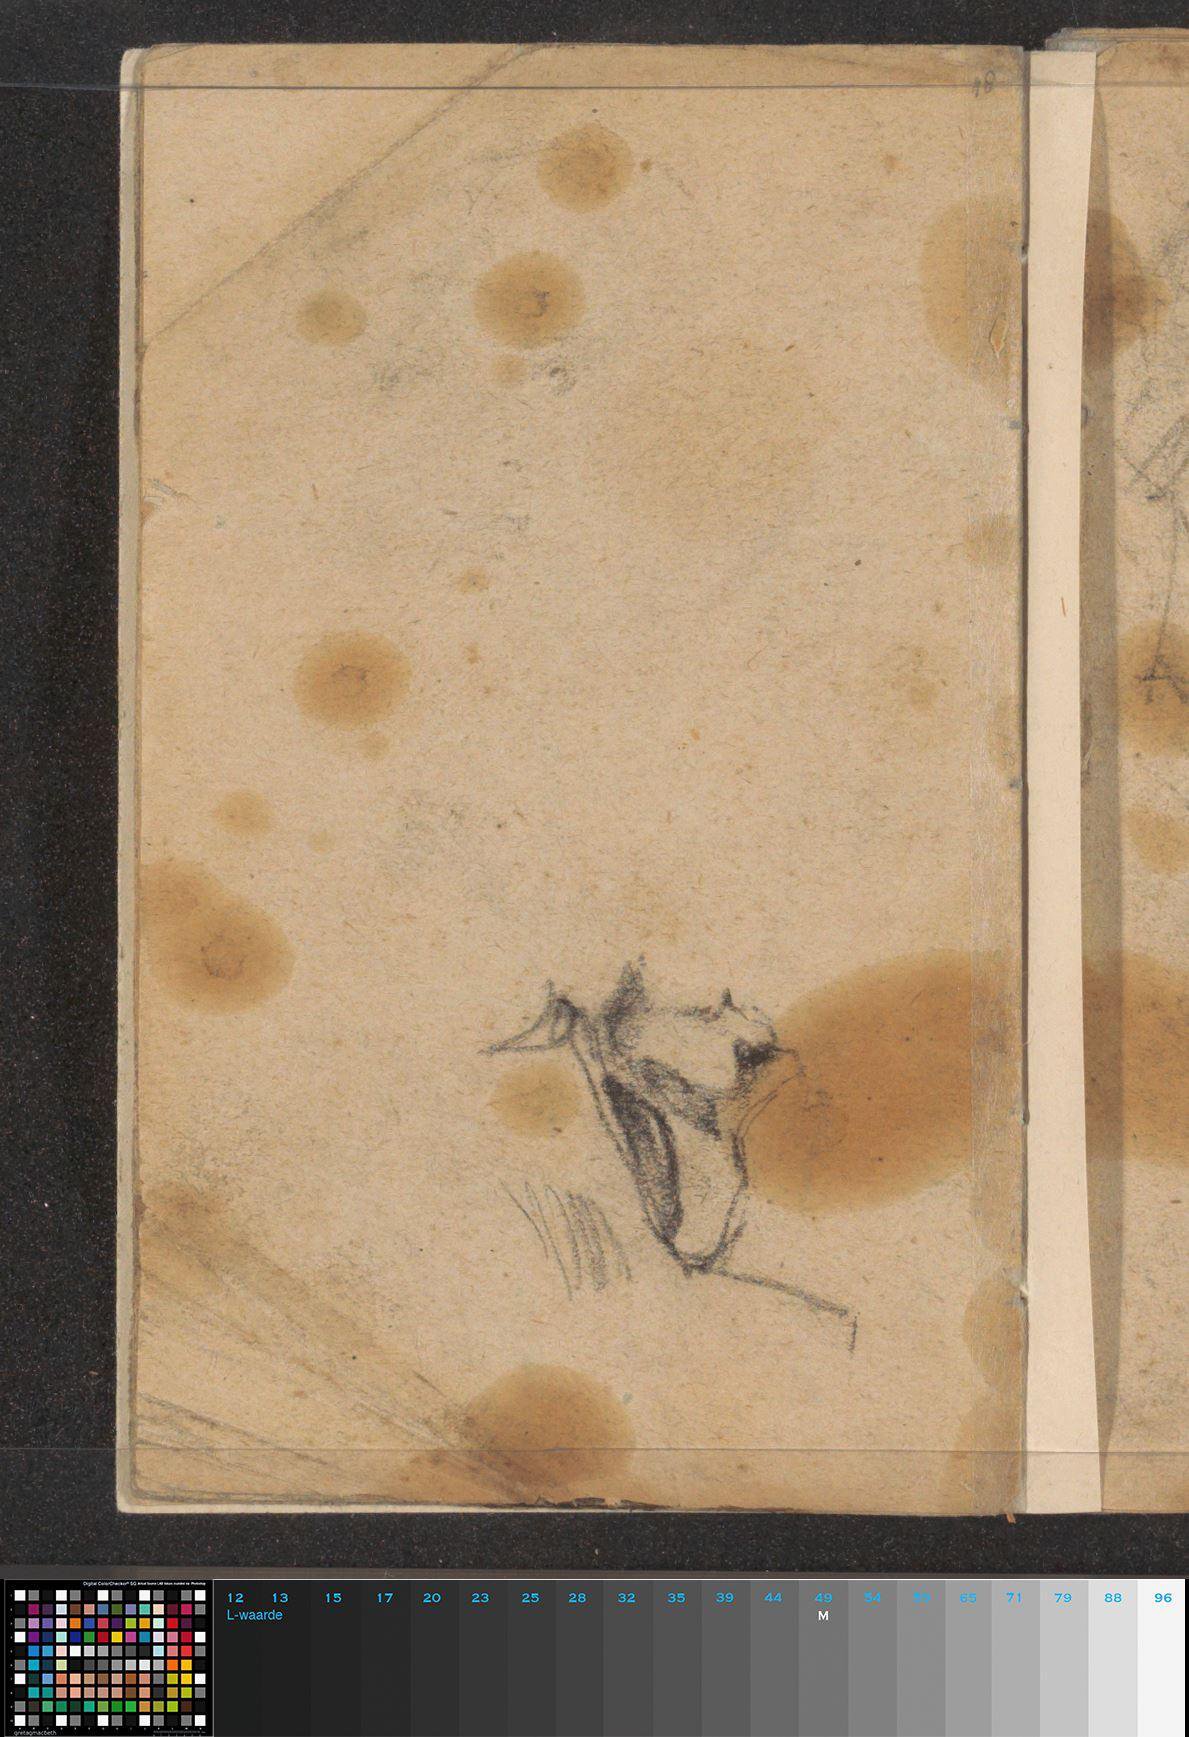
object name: sketchbook leaf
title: Jonge vrouw met muts of kap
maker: george hendrik breitner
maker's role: draughtsman, painter, print maker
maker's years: 1857-1923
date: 1881-1883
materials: chalk, paper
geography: south holland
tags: folk costume, regional costume (+ women's clothes), adolescent, young woman, maiden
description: Hoofd van een jonge vrouw met muts of kap. Pagina 18 uit een schetsboek met 43 bladen.